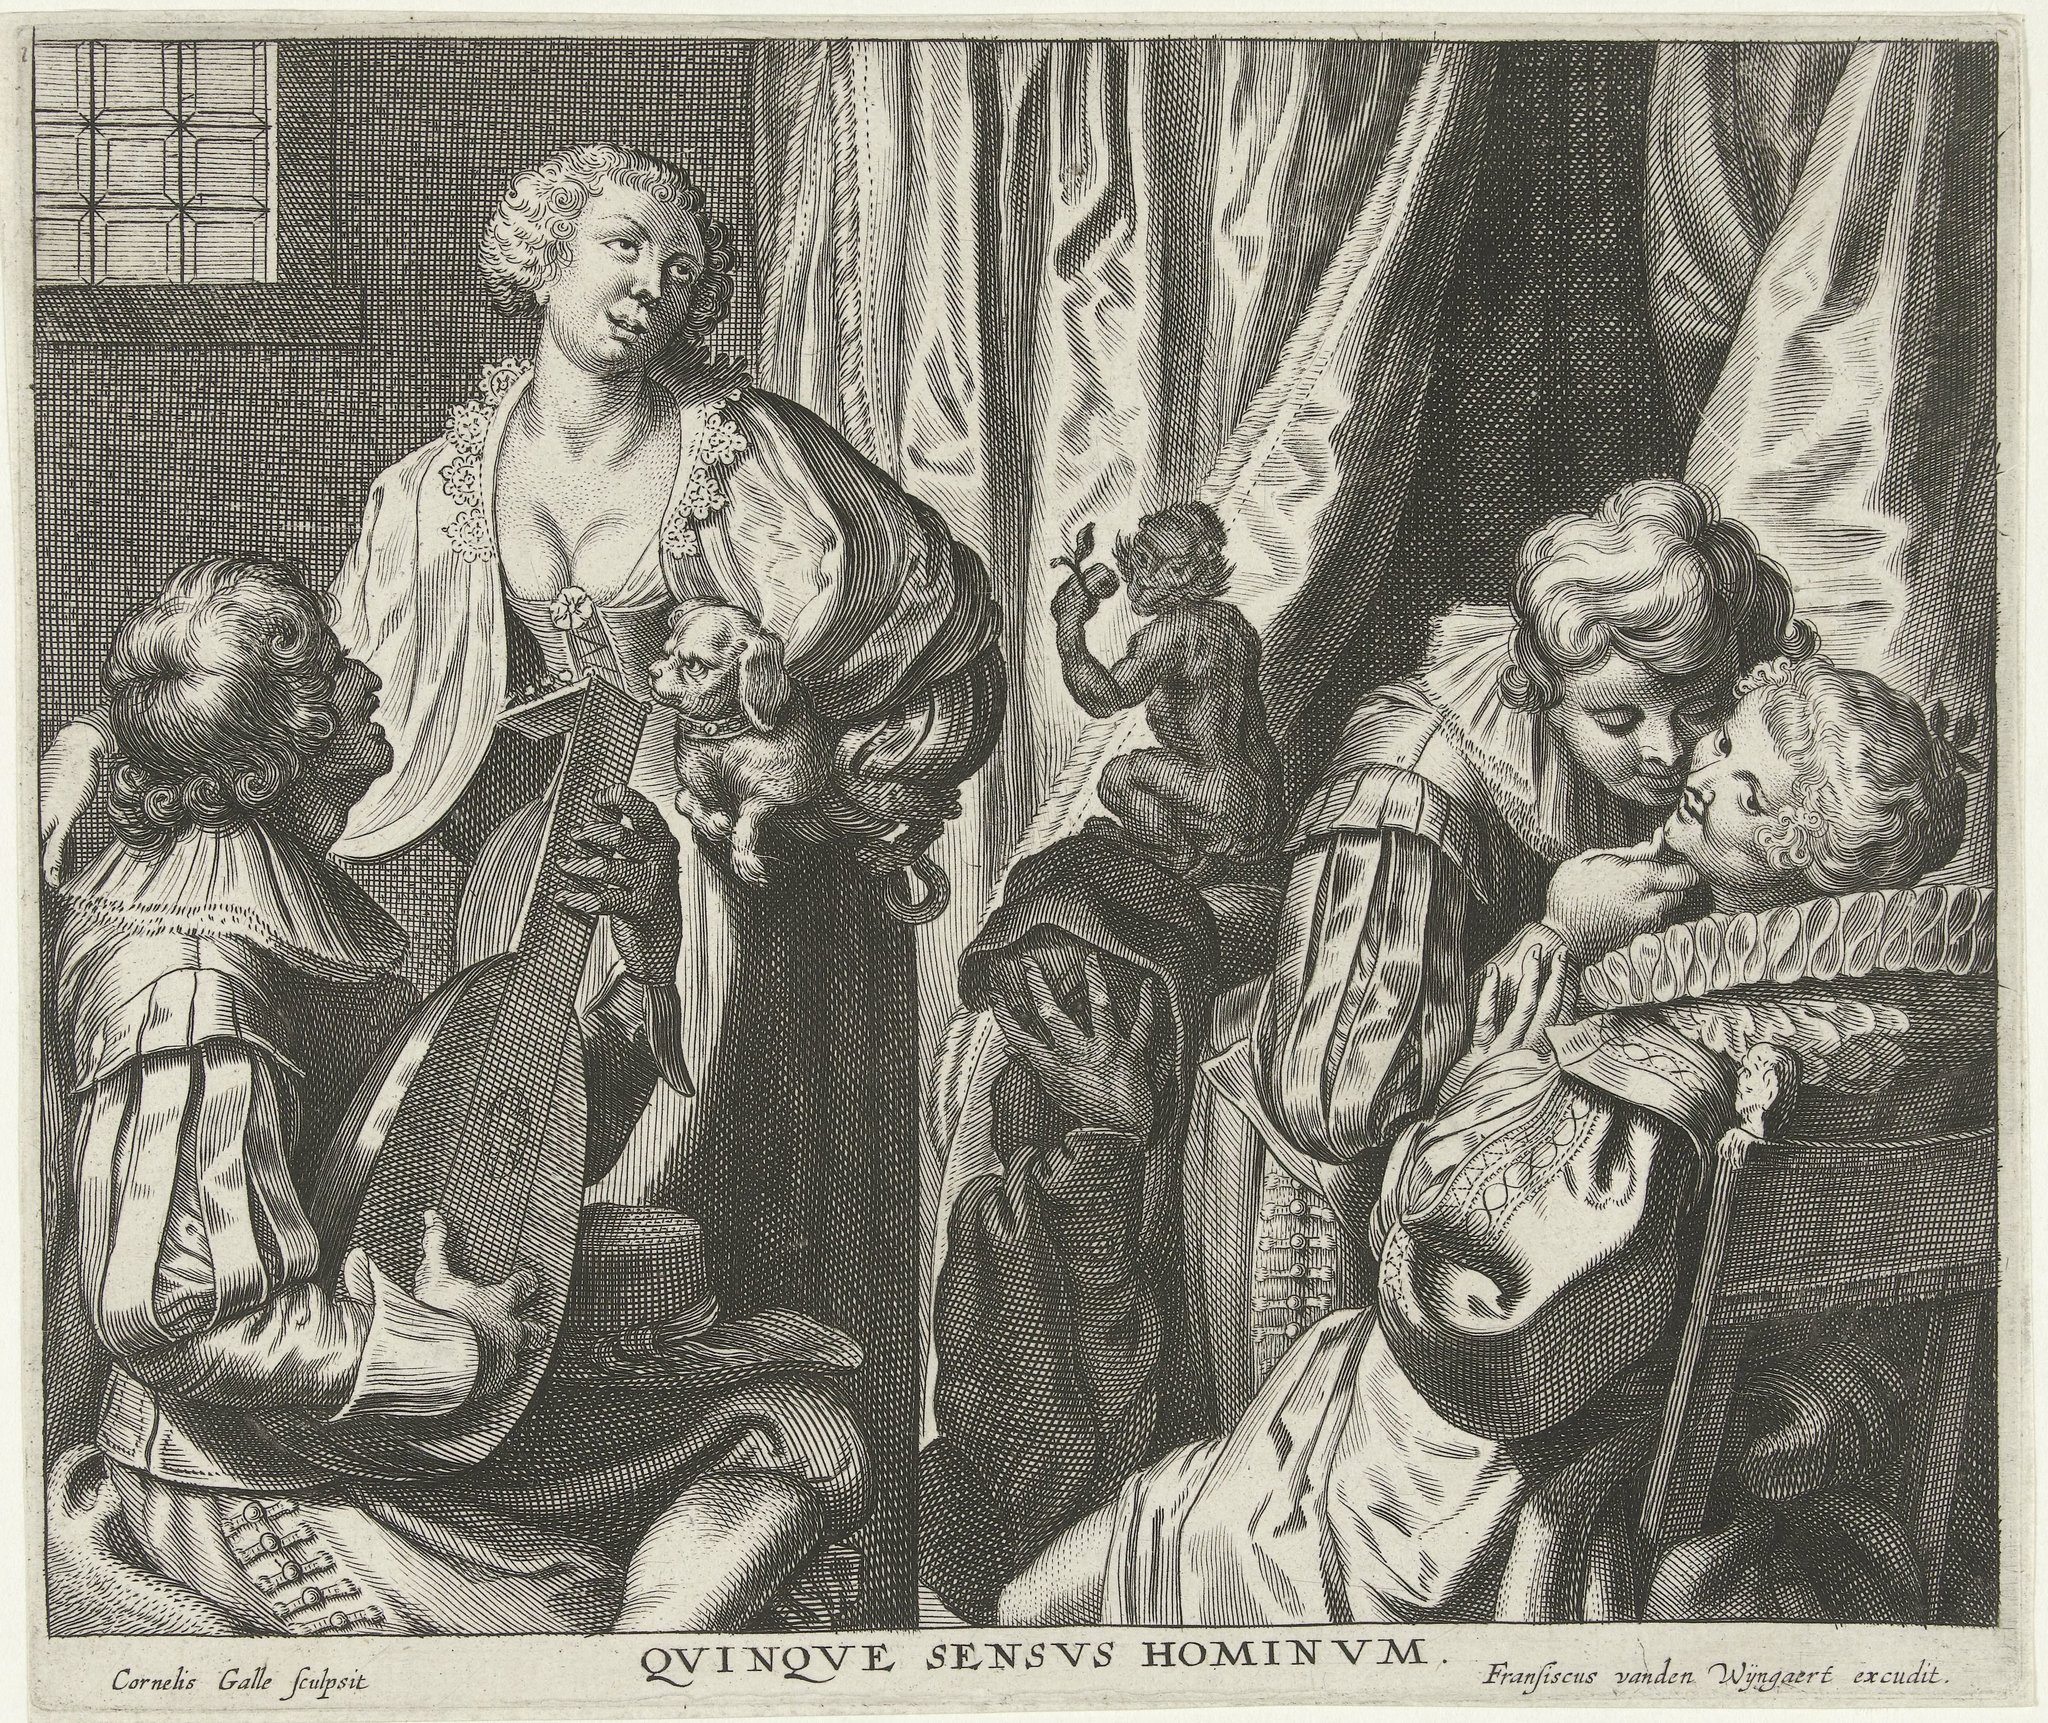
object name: print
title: De vijf zintuigen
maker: frans van den wijngaerde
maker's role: print maker, publisher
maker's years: 1614-1679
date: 1610-1678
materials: paper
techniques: engraving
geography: antwerp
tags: the (five) senses, the (five) senses - aa - female human figure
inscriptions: collector's mark: Lugt 2228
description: Allegorische voorstelling van de vijf zintuigen. Een man speelt op een luit en een vrouw luistert (gehoor), een aapje eet een vrucht (smaak), een dwaas kijkt door zijn vingers (zicht), een jongen probeert een meisje te zoenen (tast), hij snuift haar geur op (reuk).